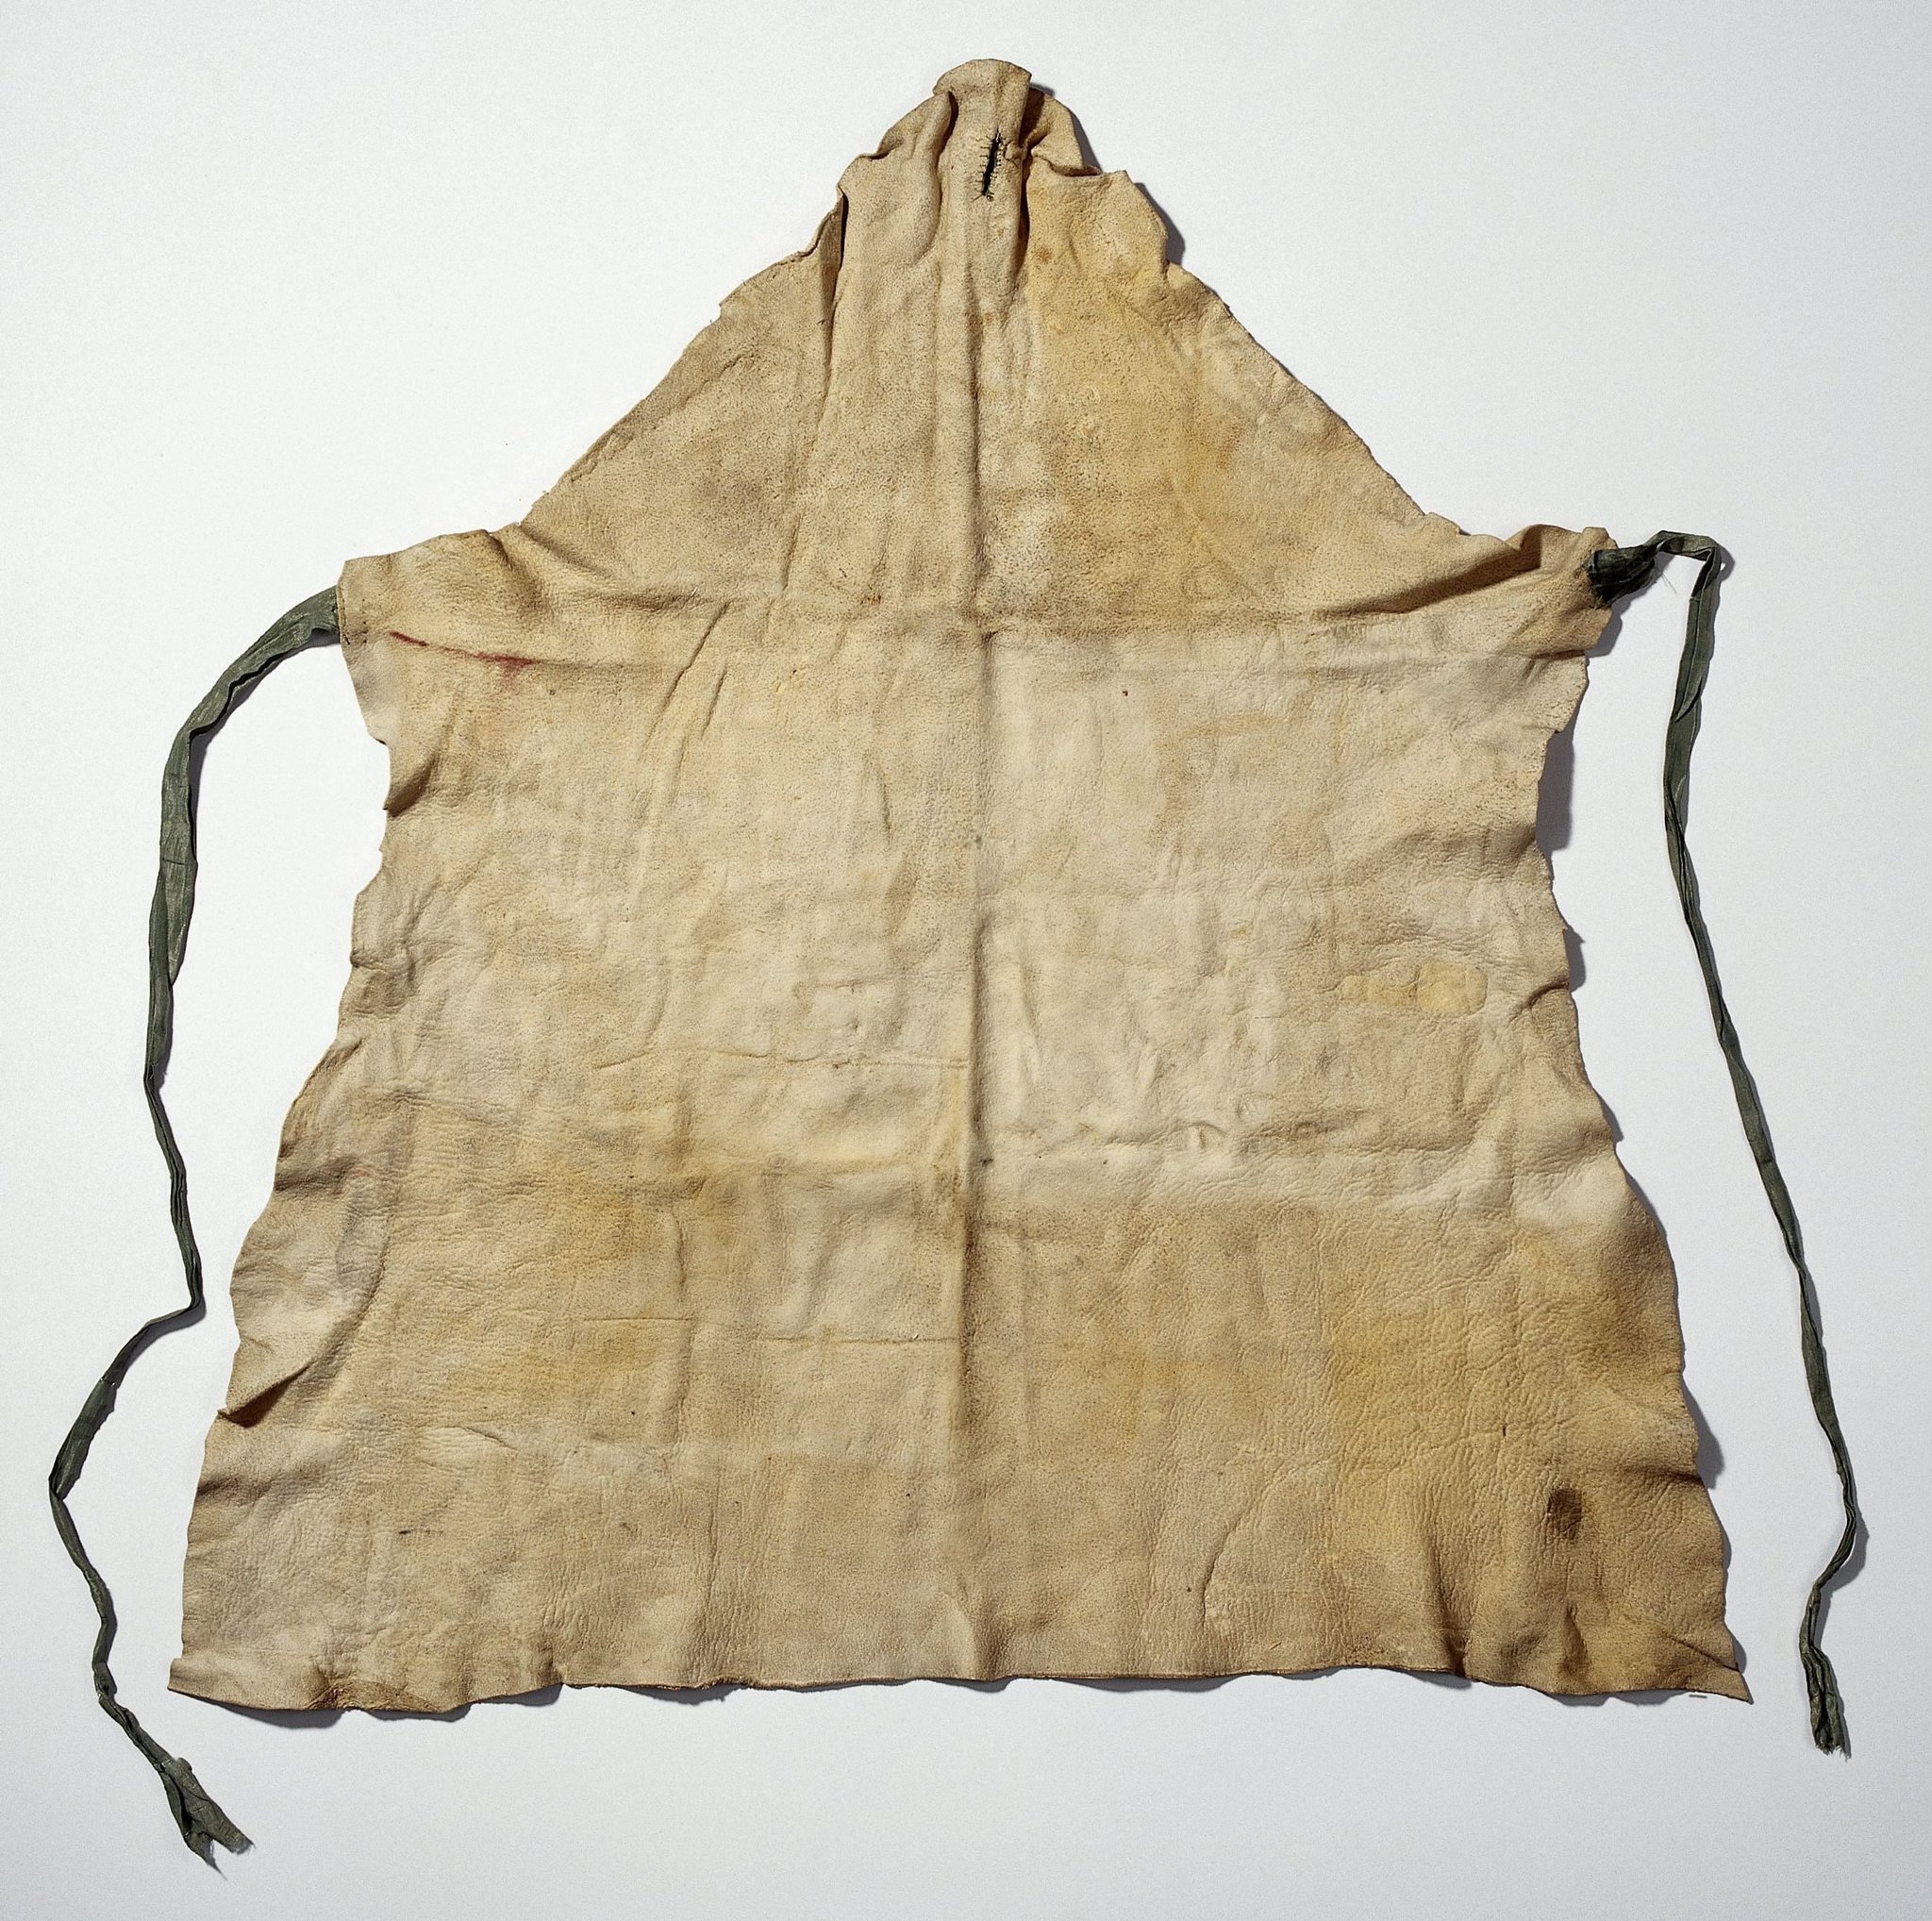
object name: voorschoot, schoot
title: Zeemleren voorschoot gebruikt bij de eerste steenlegging in 1648 van het Amsterdamse stadhuis (het paleis) op de Dam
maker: Anonymous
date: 1648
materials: leather, silk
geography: netherlands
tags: royal palace of amsterdam, amsterdam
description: Vijfhoekige zeemleren. In de bovenhoek zit een groen omzoomd knoopsgat. Aan de beide zijkanten is een groen zijden lint genaaid. Er is een handgeschreven briefje op het voorschoot genaaid. Zie BK-KOG-1494.